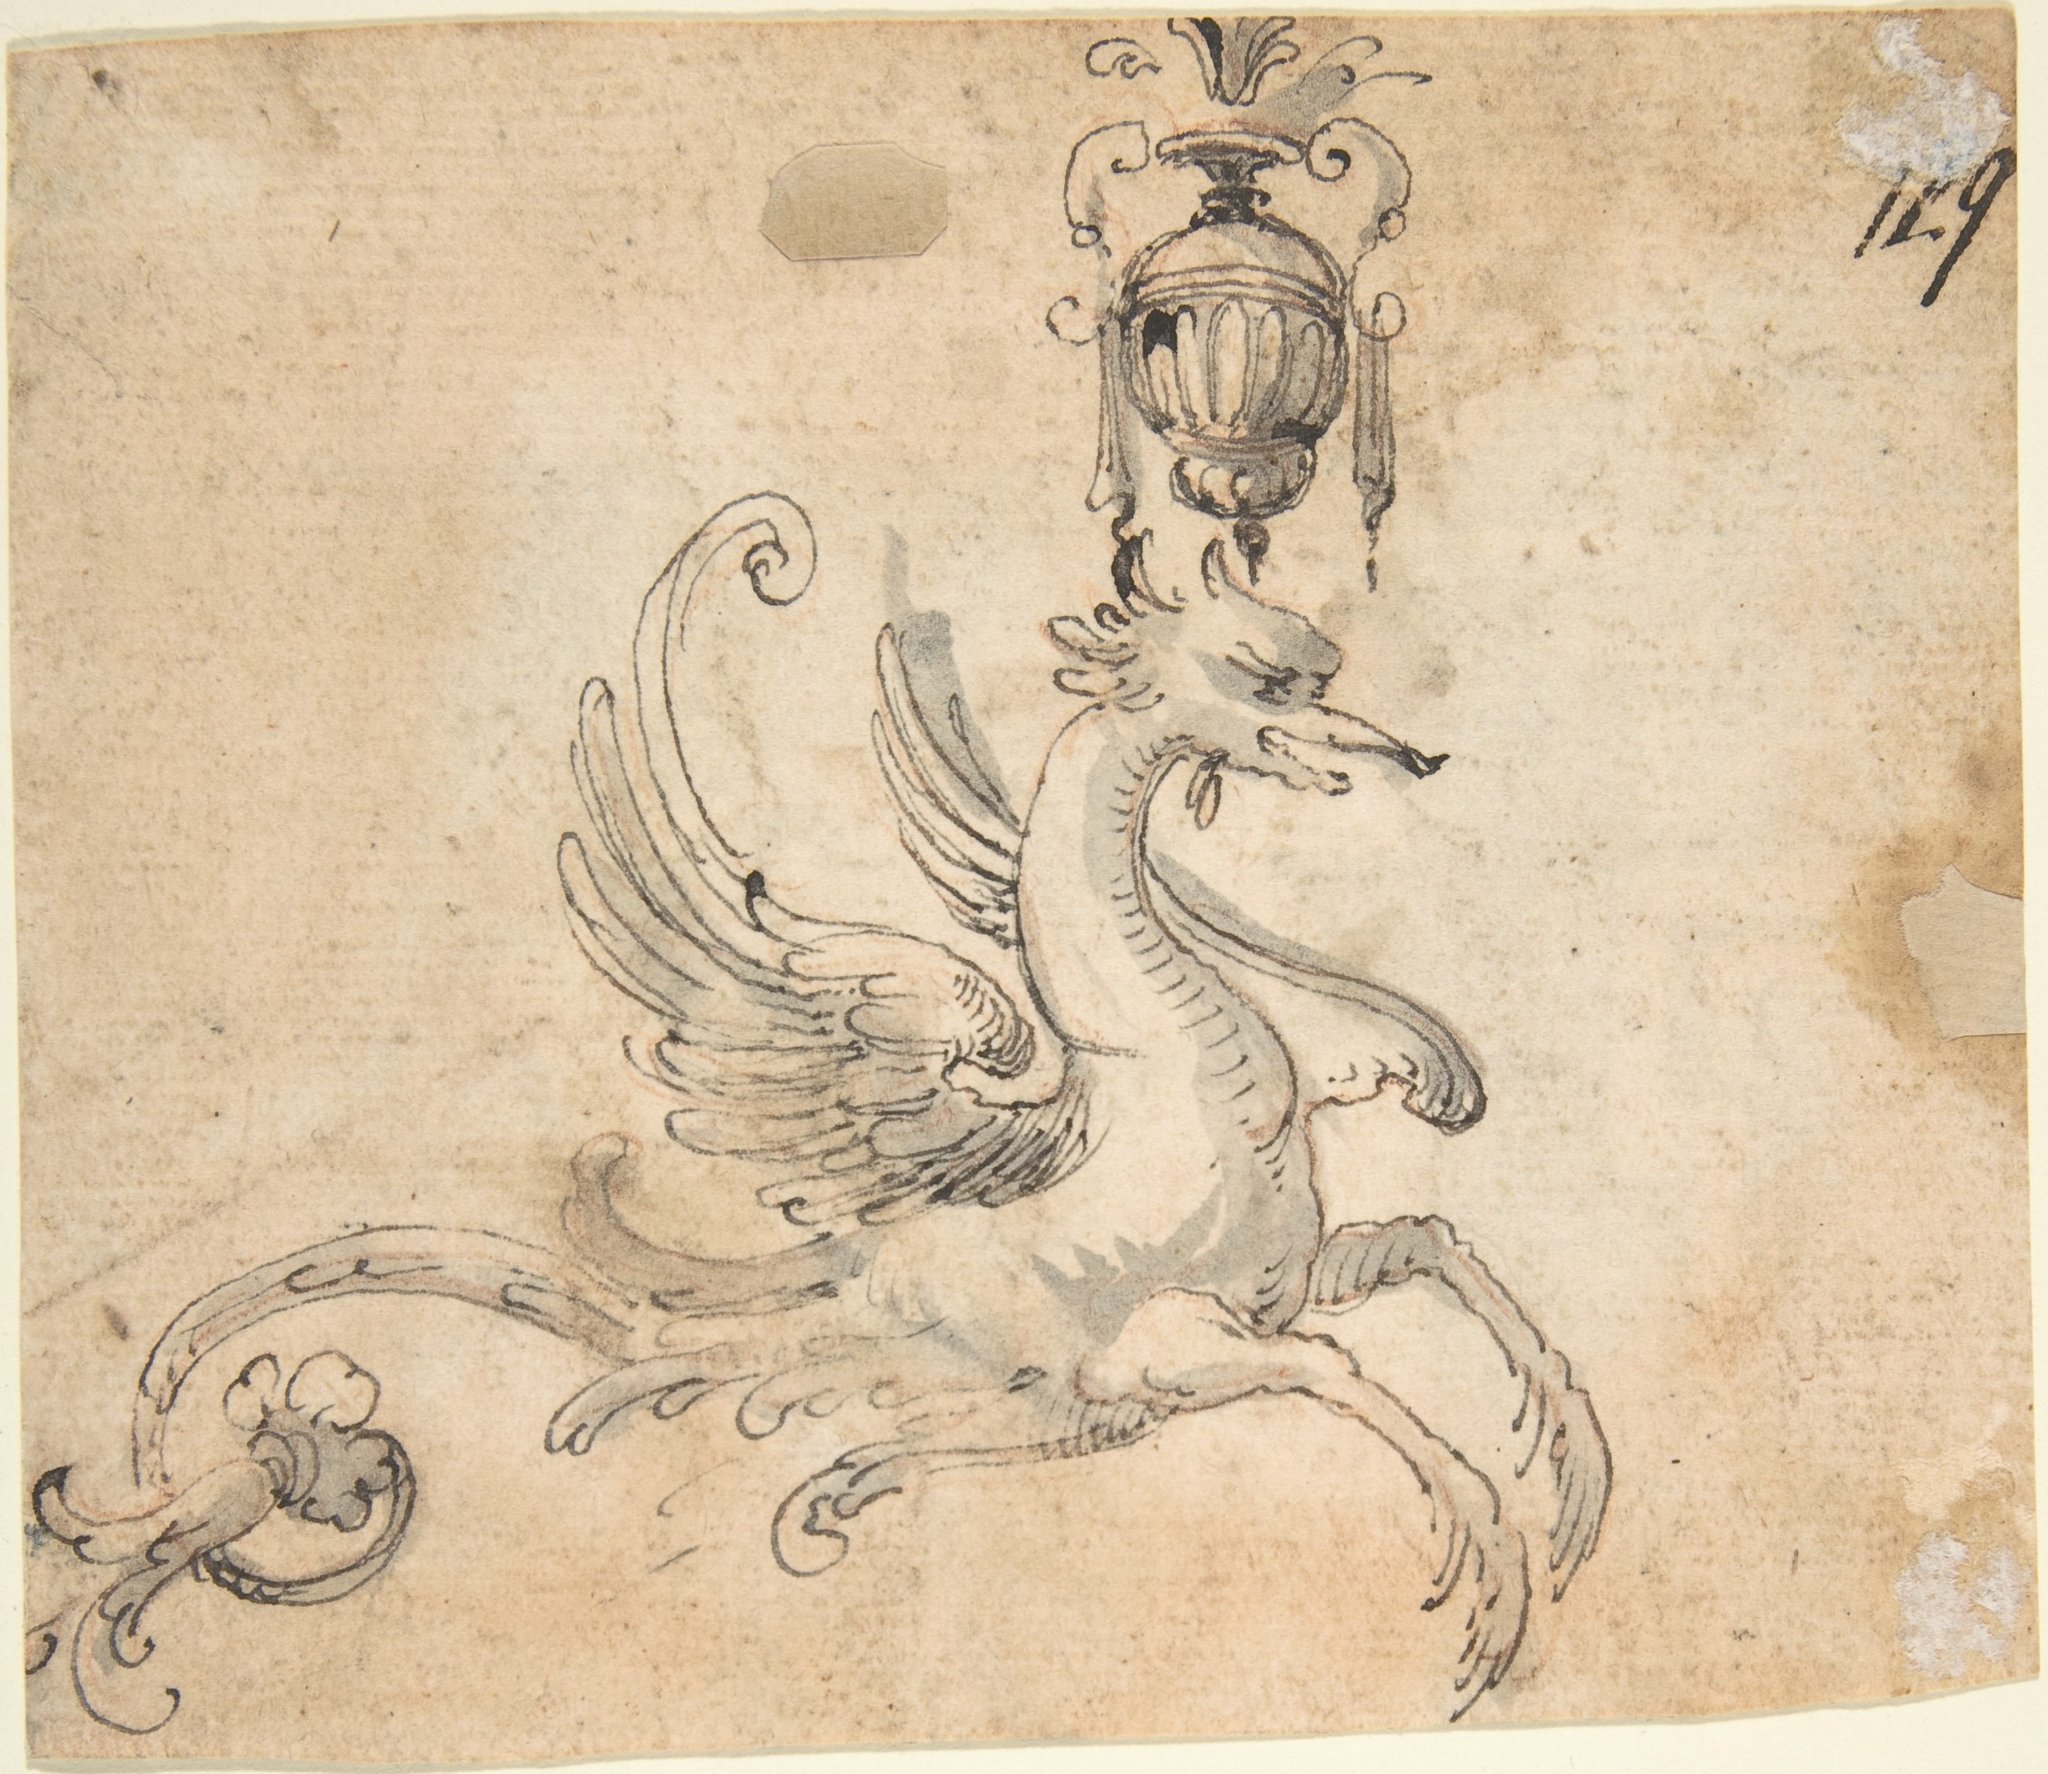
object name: drawing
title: Winged Hippocamp supporting a Vase (recto); Figure Studies and Architectural Design (verso)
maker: anonymous, italian, 16th to early 17th century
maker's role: artist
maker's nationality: italian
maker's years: 1500-1640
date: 1501-1633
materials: chalk, ink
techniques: brush, pen, wash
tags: hippocamps